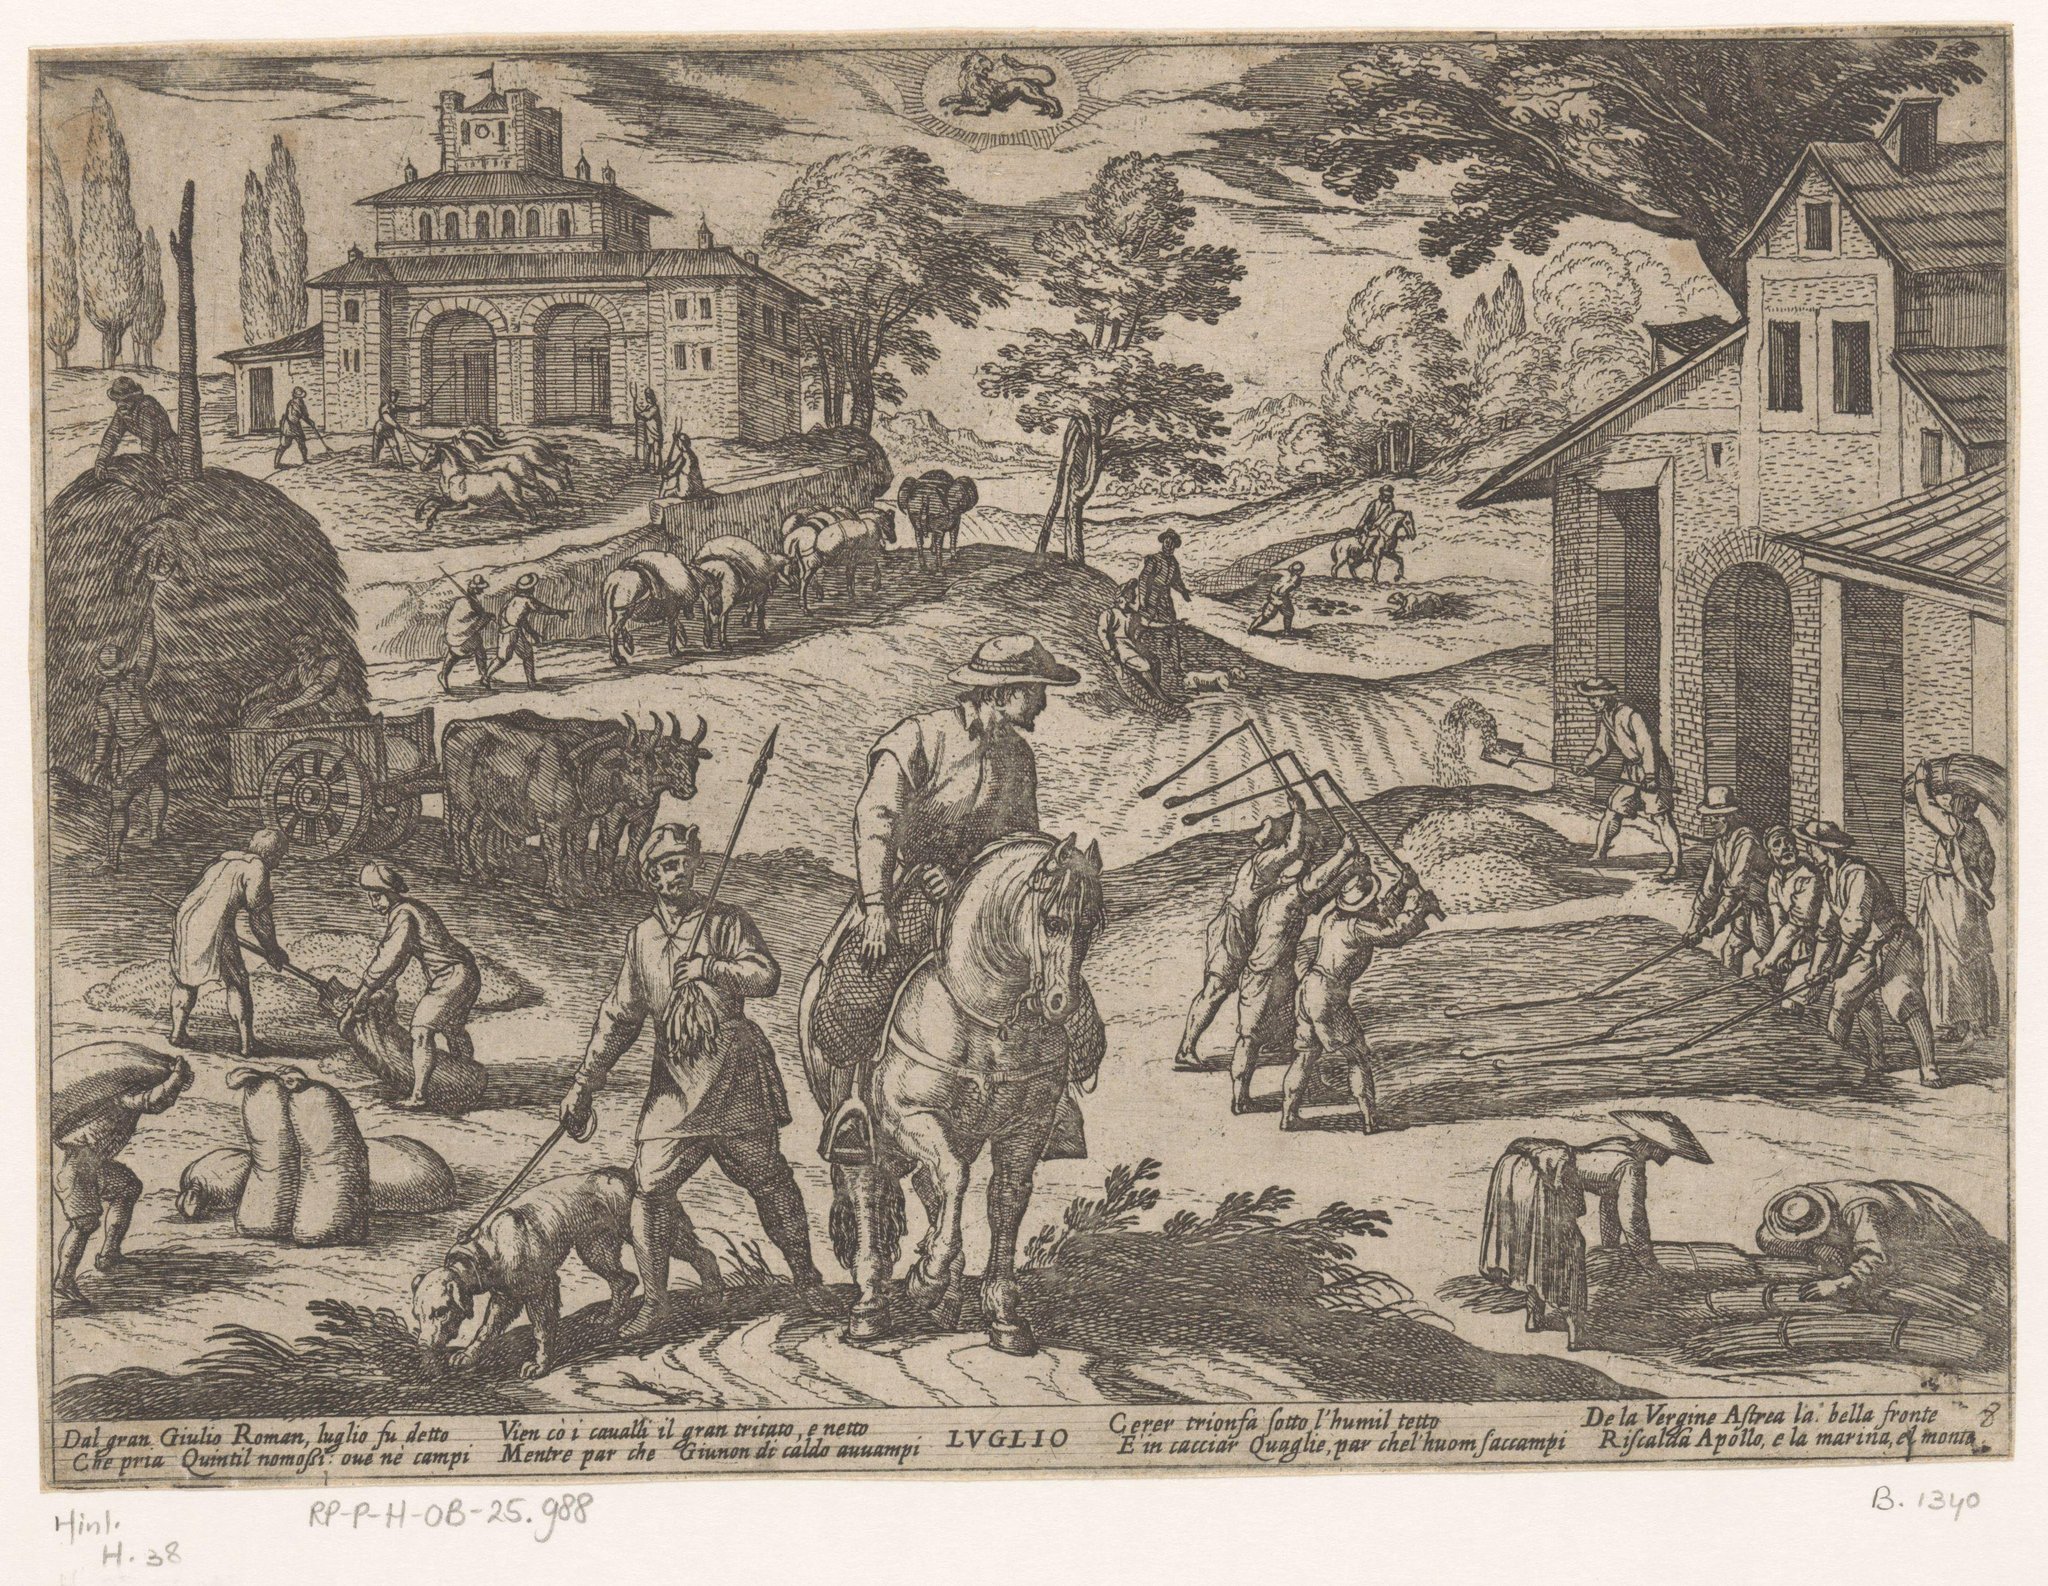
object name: print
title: De twaalf maanden (deel 1)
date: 1599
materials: paper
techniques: etching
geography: italy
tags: the twelve months represented by scenes showing human activities, usually in a landscape; so-called 'labours of the months', hunters hunting (n.b.: in 1988-1990 this notation denoted the concept of 43c11421 'hunters resting during the hunt'), cereal, grain, corn (grass with grains, grown for food, e.g.: wheat, rice, rye, oats, maize, buckwheat, millet), threshing, leo (zodiacal sign of july)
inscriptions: collector's mark: ‘Hinloopen’, collector's mark: Lugt 11, number: ‘8’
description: Verbeelding van menselijke activiteit in de maand juli. Landschap met boeren die graan bewerken en verpakken. Op de achtergrond vogeljagers. Midden boven het symbool voor het sterrenbeeld leeuw. Italiaans vers en titel in ondermarge.